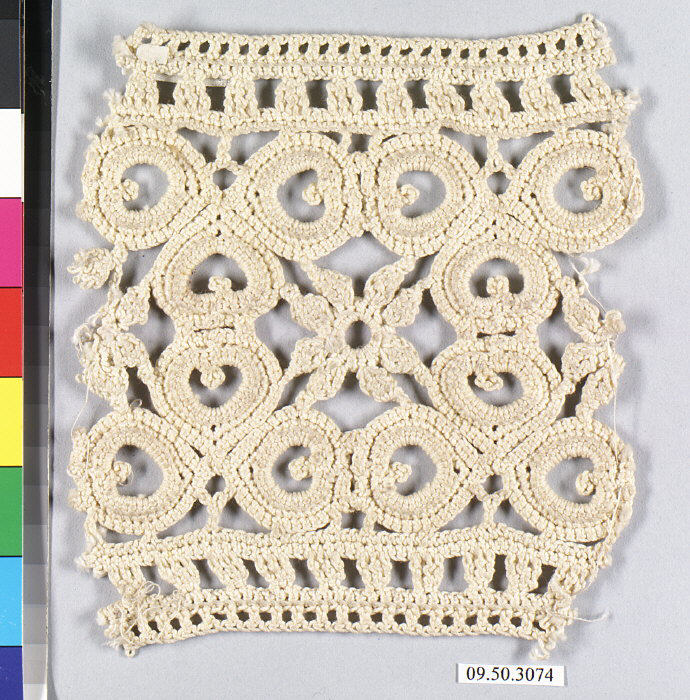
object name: sample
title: Crochet Work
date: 1801-1900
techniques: crochet